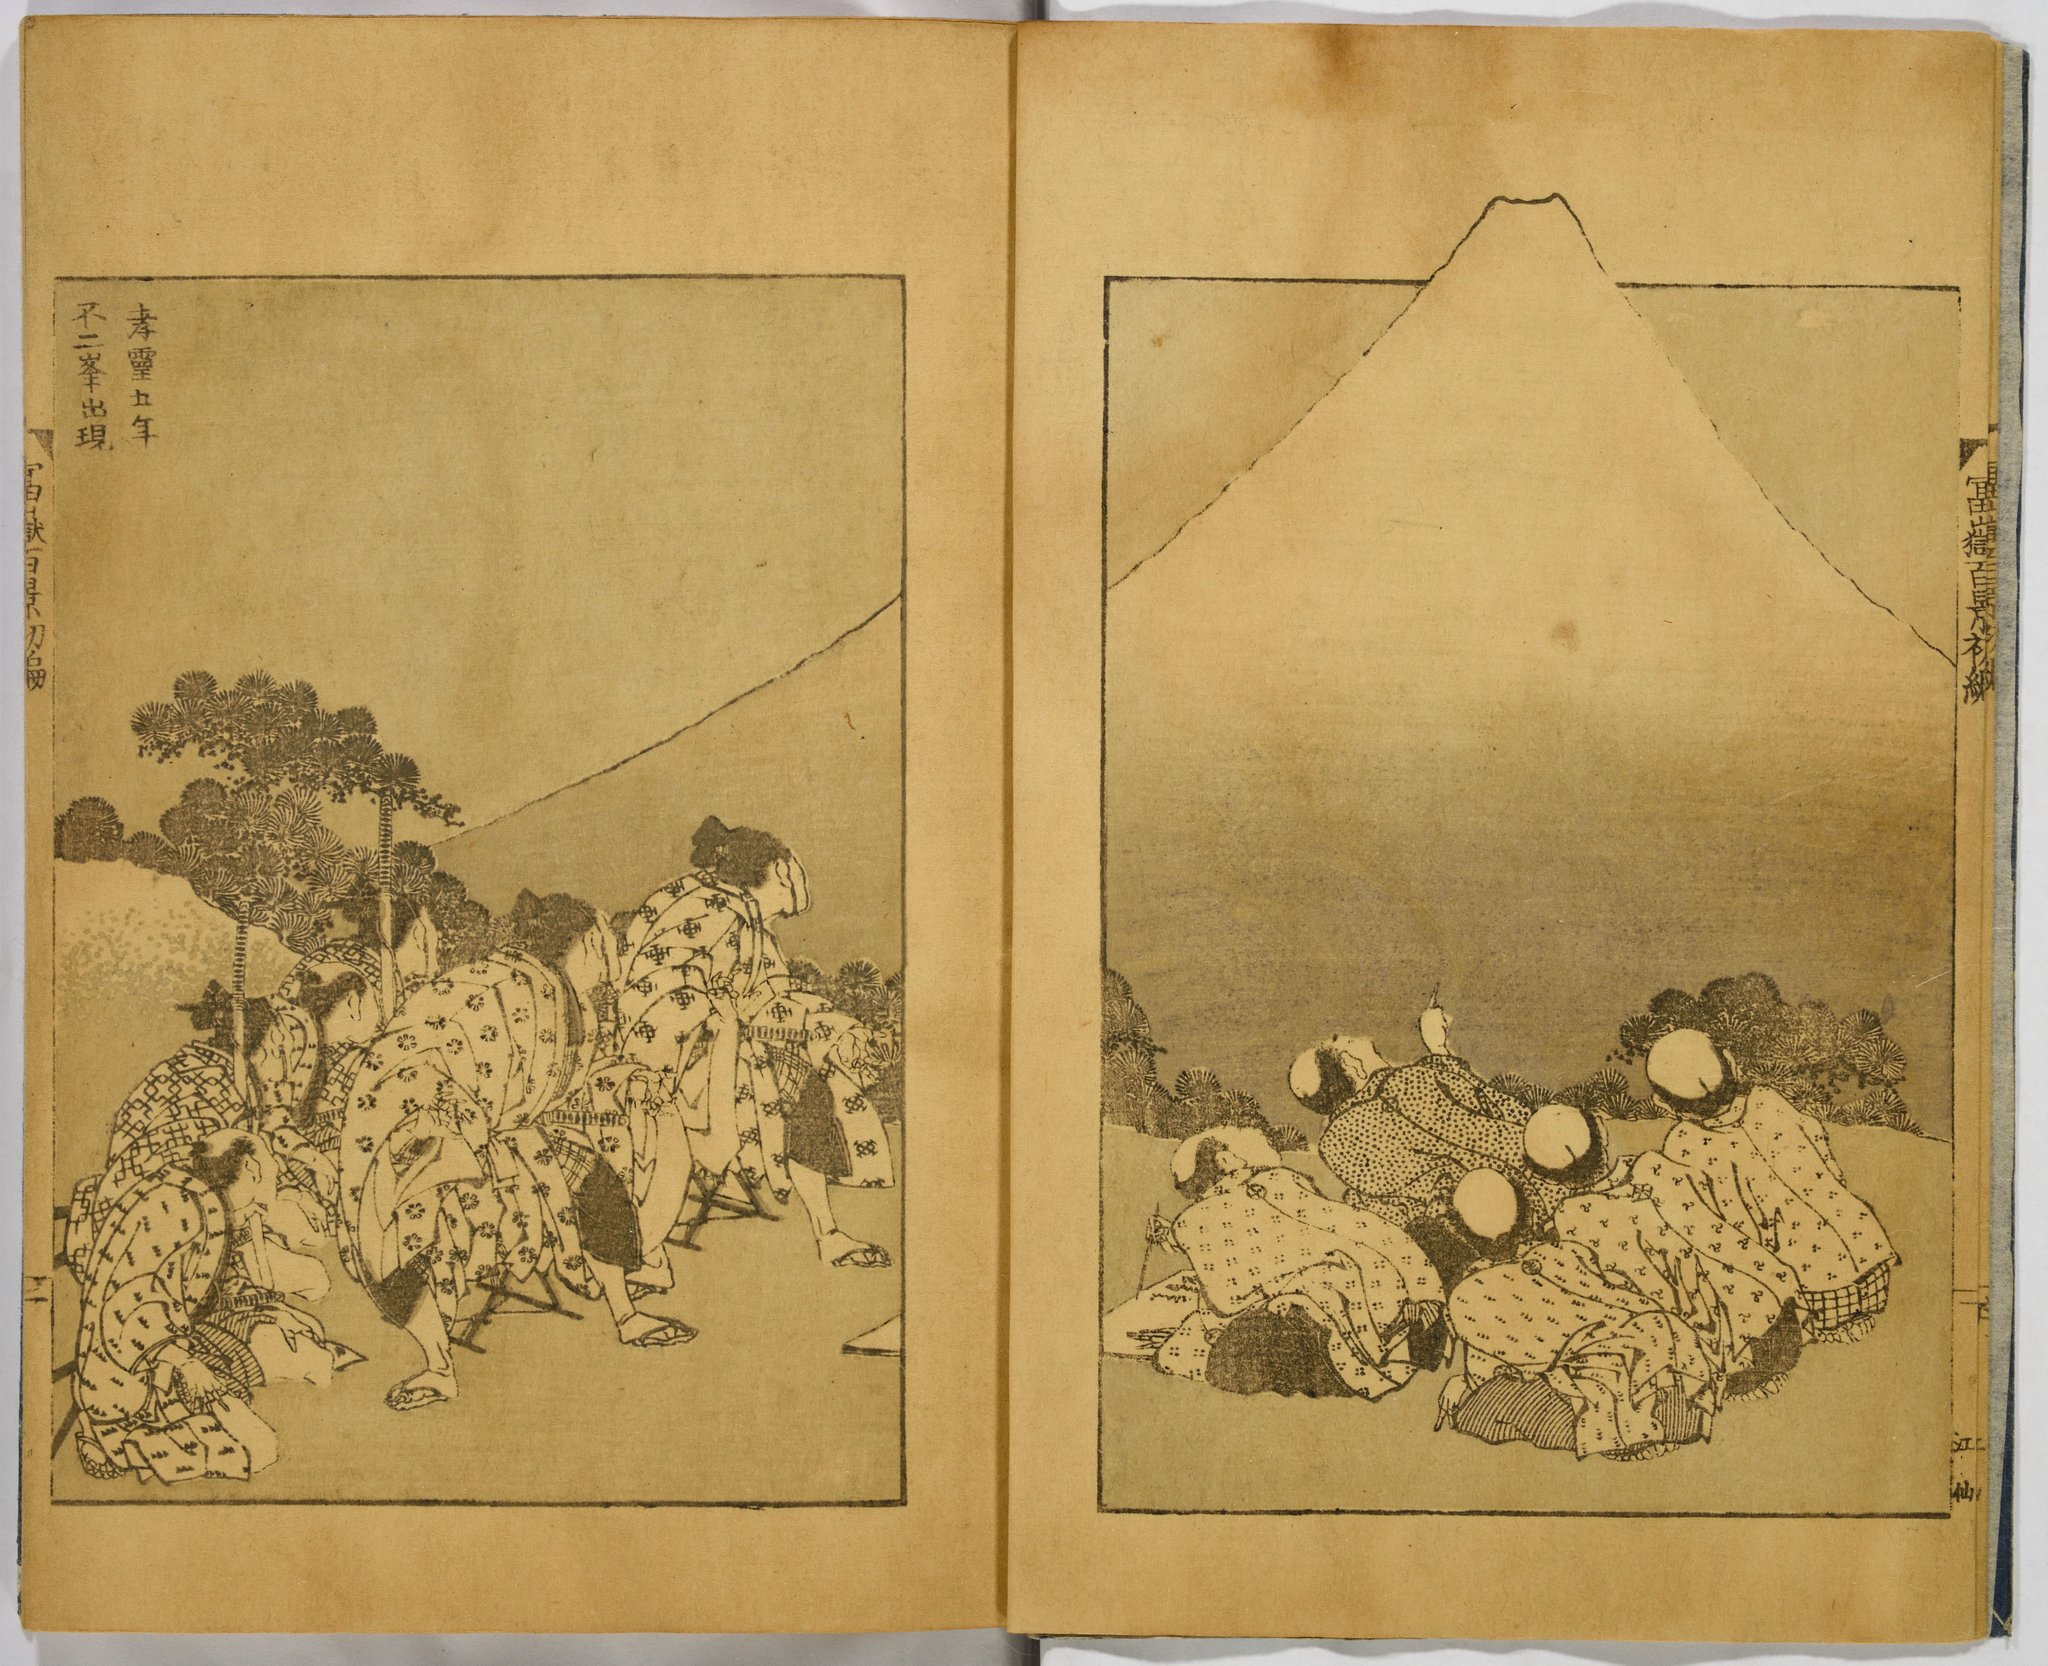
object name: illustrated book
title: Hundred Views of Fuji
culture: japanese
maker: katsushika hokusai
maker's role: artist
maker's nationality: japanese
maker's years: 1760-1849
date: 1834-1835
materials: ink, paper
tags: men,mountains,trees